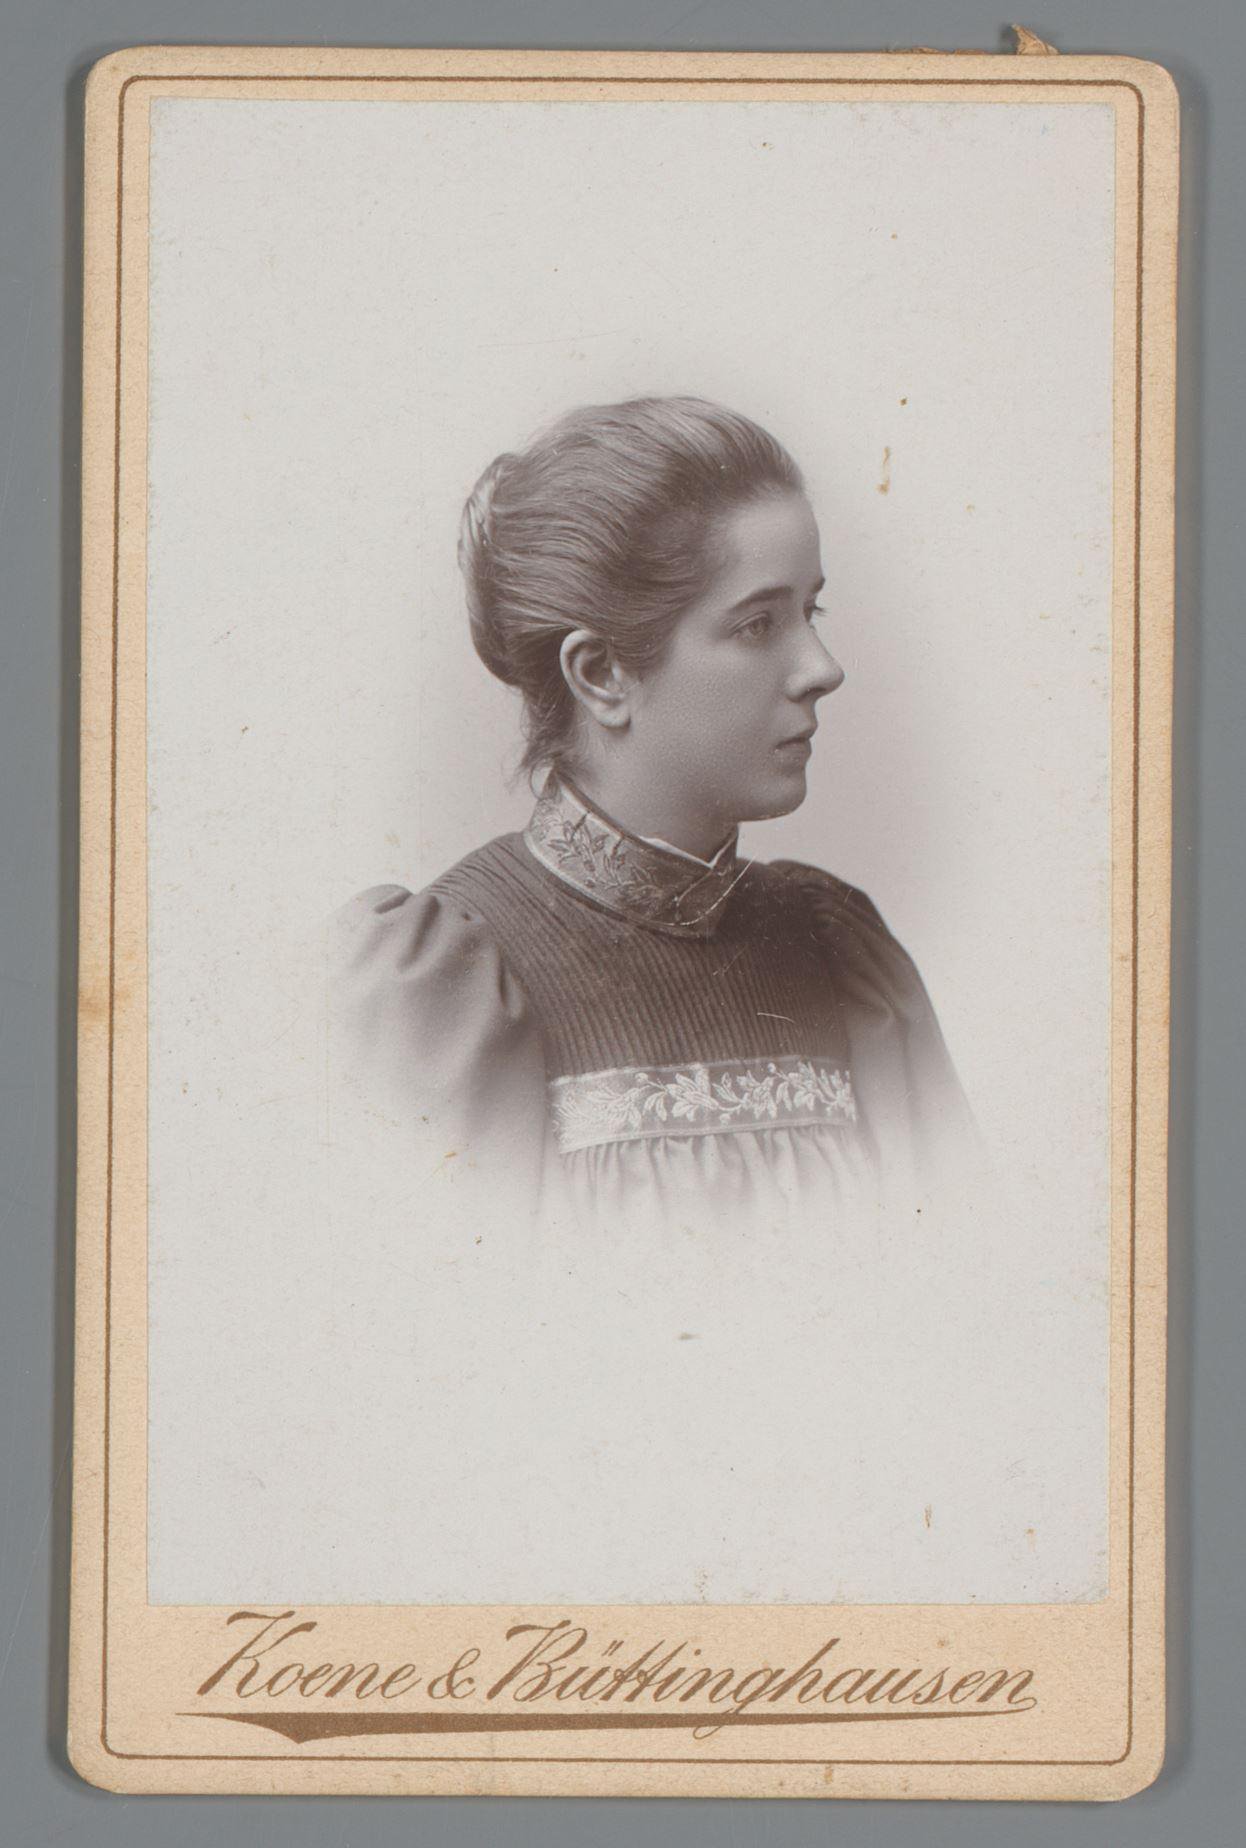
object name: carte de visite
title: Portret van Cornelia Hendrika Jonker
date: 1877-1920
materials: cardboard, photographic support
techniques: collodion silver print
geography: amsterdam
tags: cornelia hendrika jonker, historical persons, amsterdam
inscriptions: workshop stamp: ‘Koene & Büttinghausen/ Amsterdan, Heerengracht 150/ Batavia’, name: ‘C.H. Jonker’